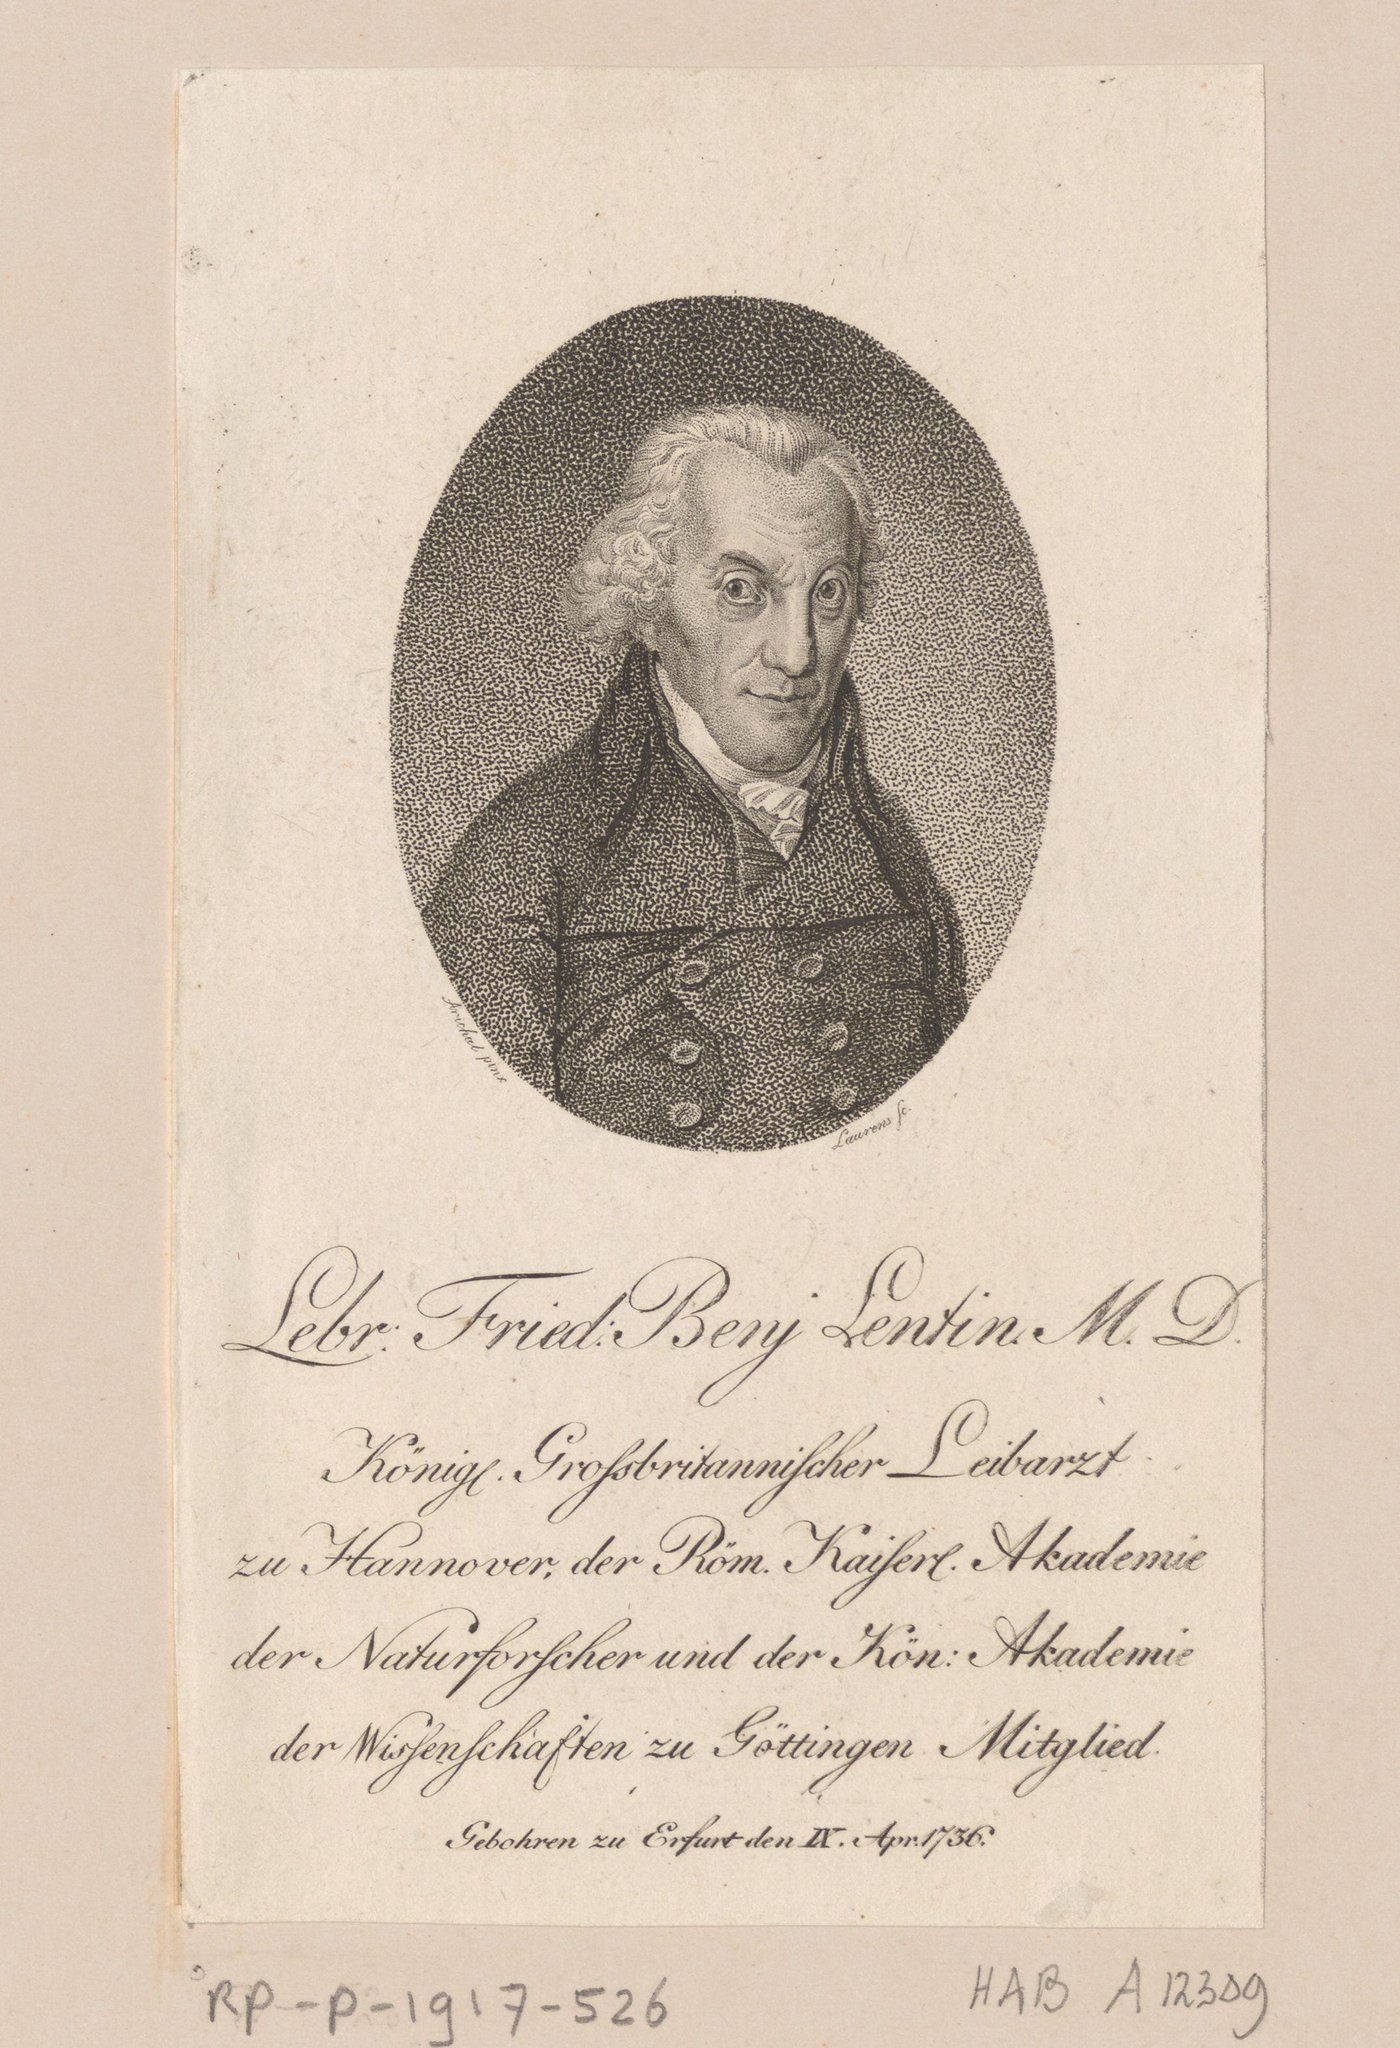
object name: print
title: Portret van Lebrecht Friedrich Benjamin Lentin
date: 1795-1804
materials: paper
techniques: etching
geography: berlin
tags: historical persons, physician, doctor (+ portrait of scholar, scientist)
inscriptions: collector's mark: Lugt 2228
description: Met tekst in het Duits onder het portret.